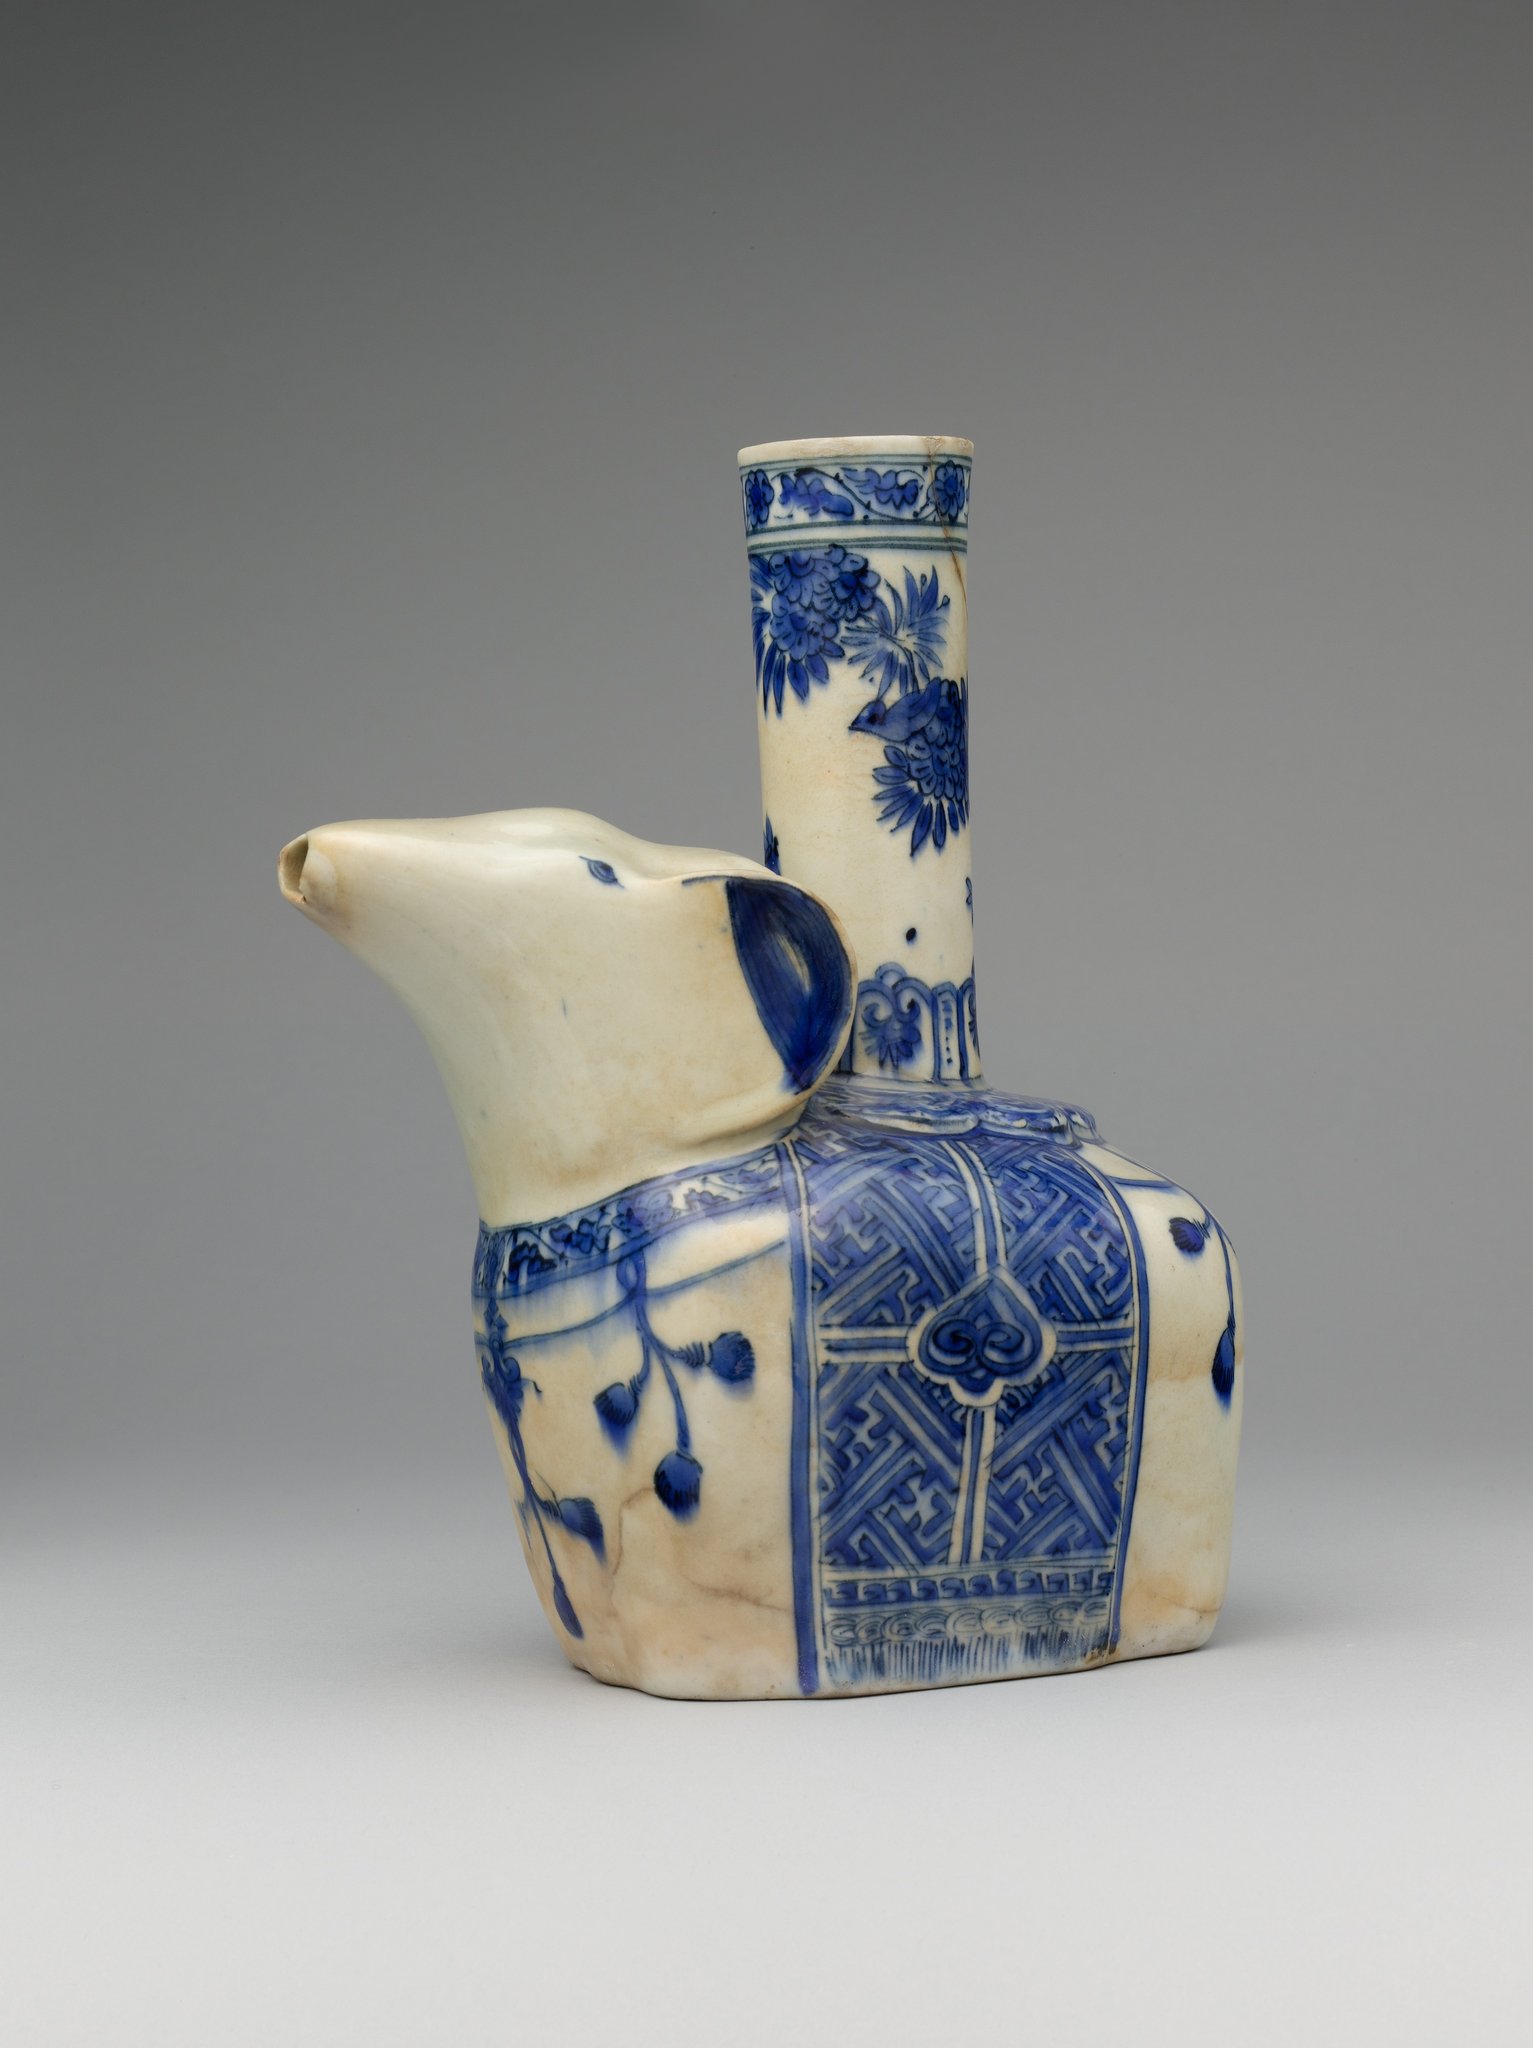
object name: kendi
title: Elephant-Shaped Kendi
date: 1626-1650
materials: glaze, stonepaste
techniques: painting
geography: iran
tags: elephants